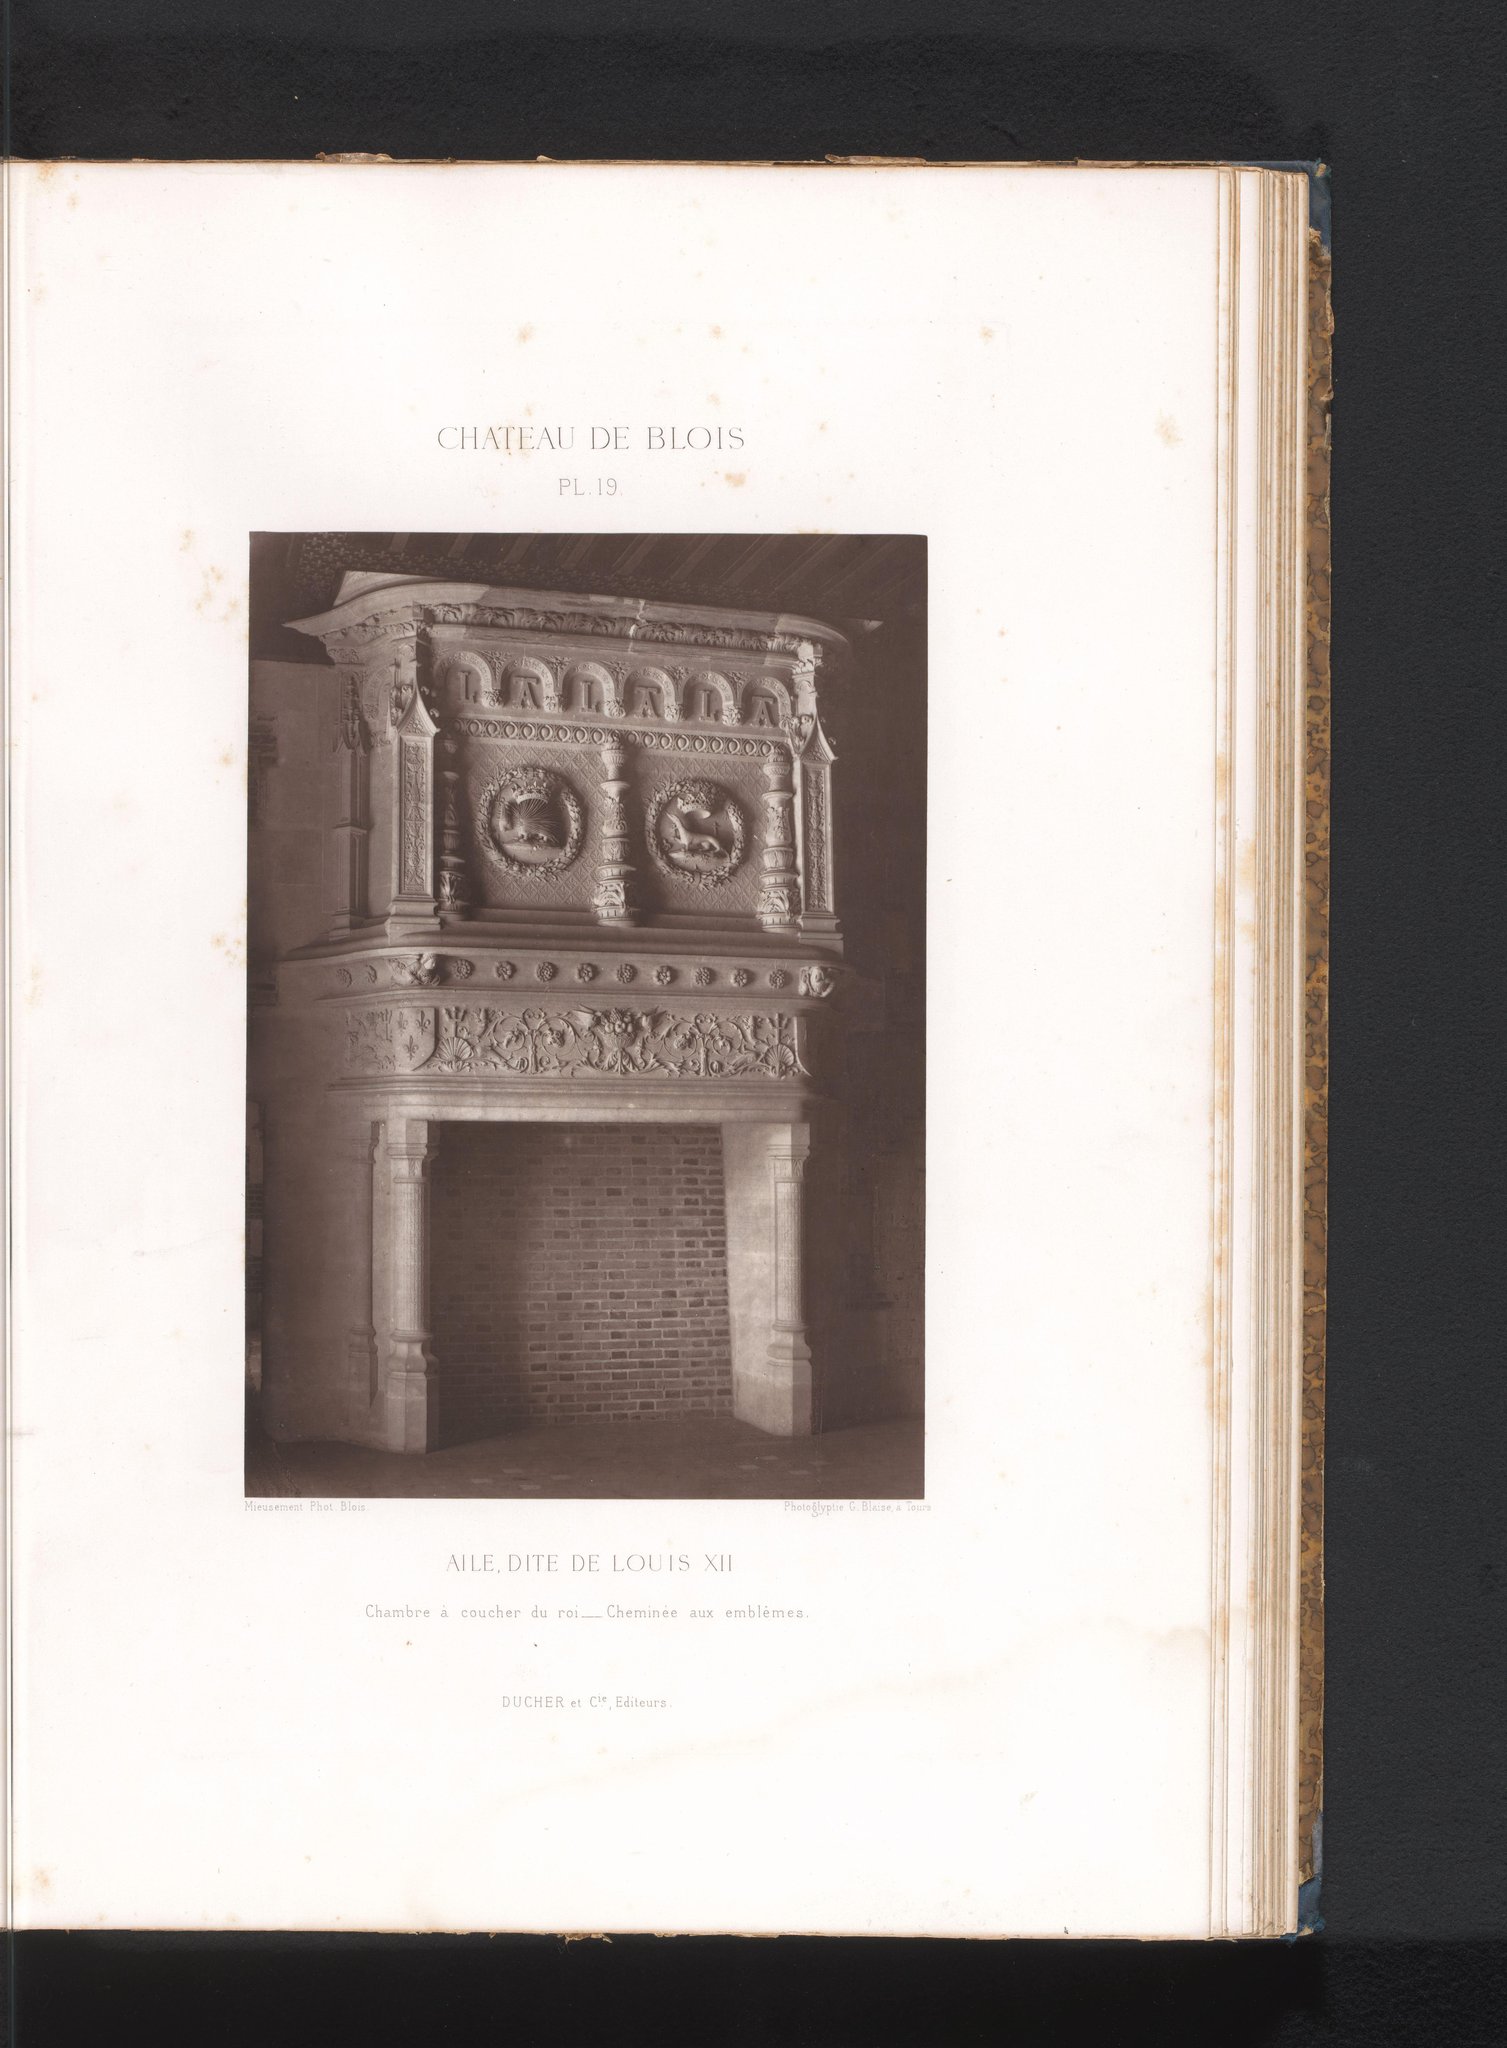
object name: page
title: Aile, dite de Louis XII. Chambre à coucher du roi - Cheminée aux emblêmes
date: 1870-1875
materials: paper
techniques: woodburytype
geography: blois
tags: castle, chimney-piece, mantelpiece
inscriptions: number: ‘PL. 19.’